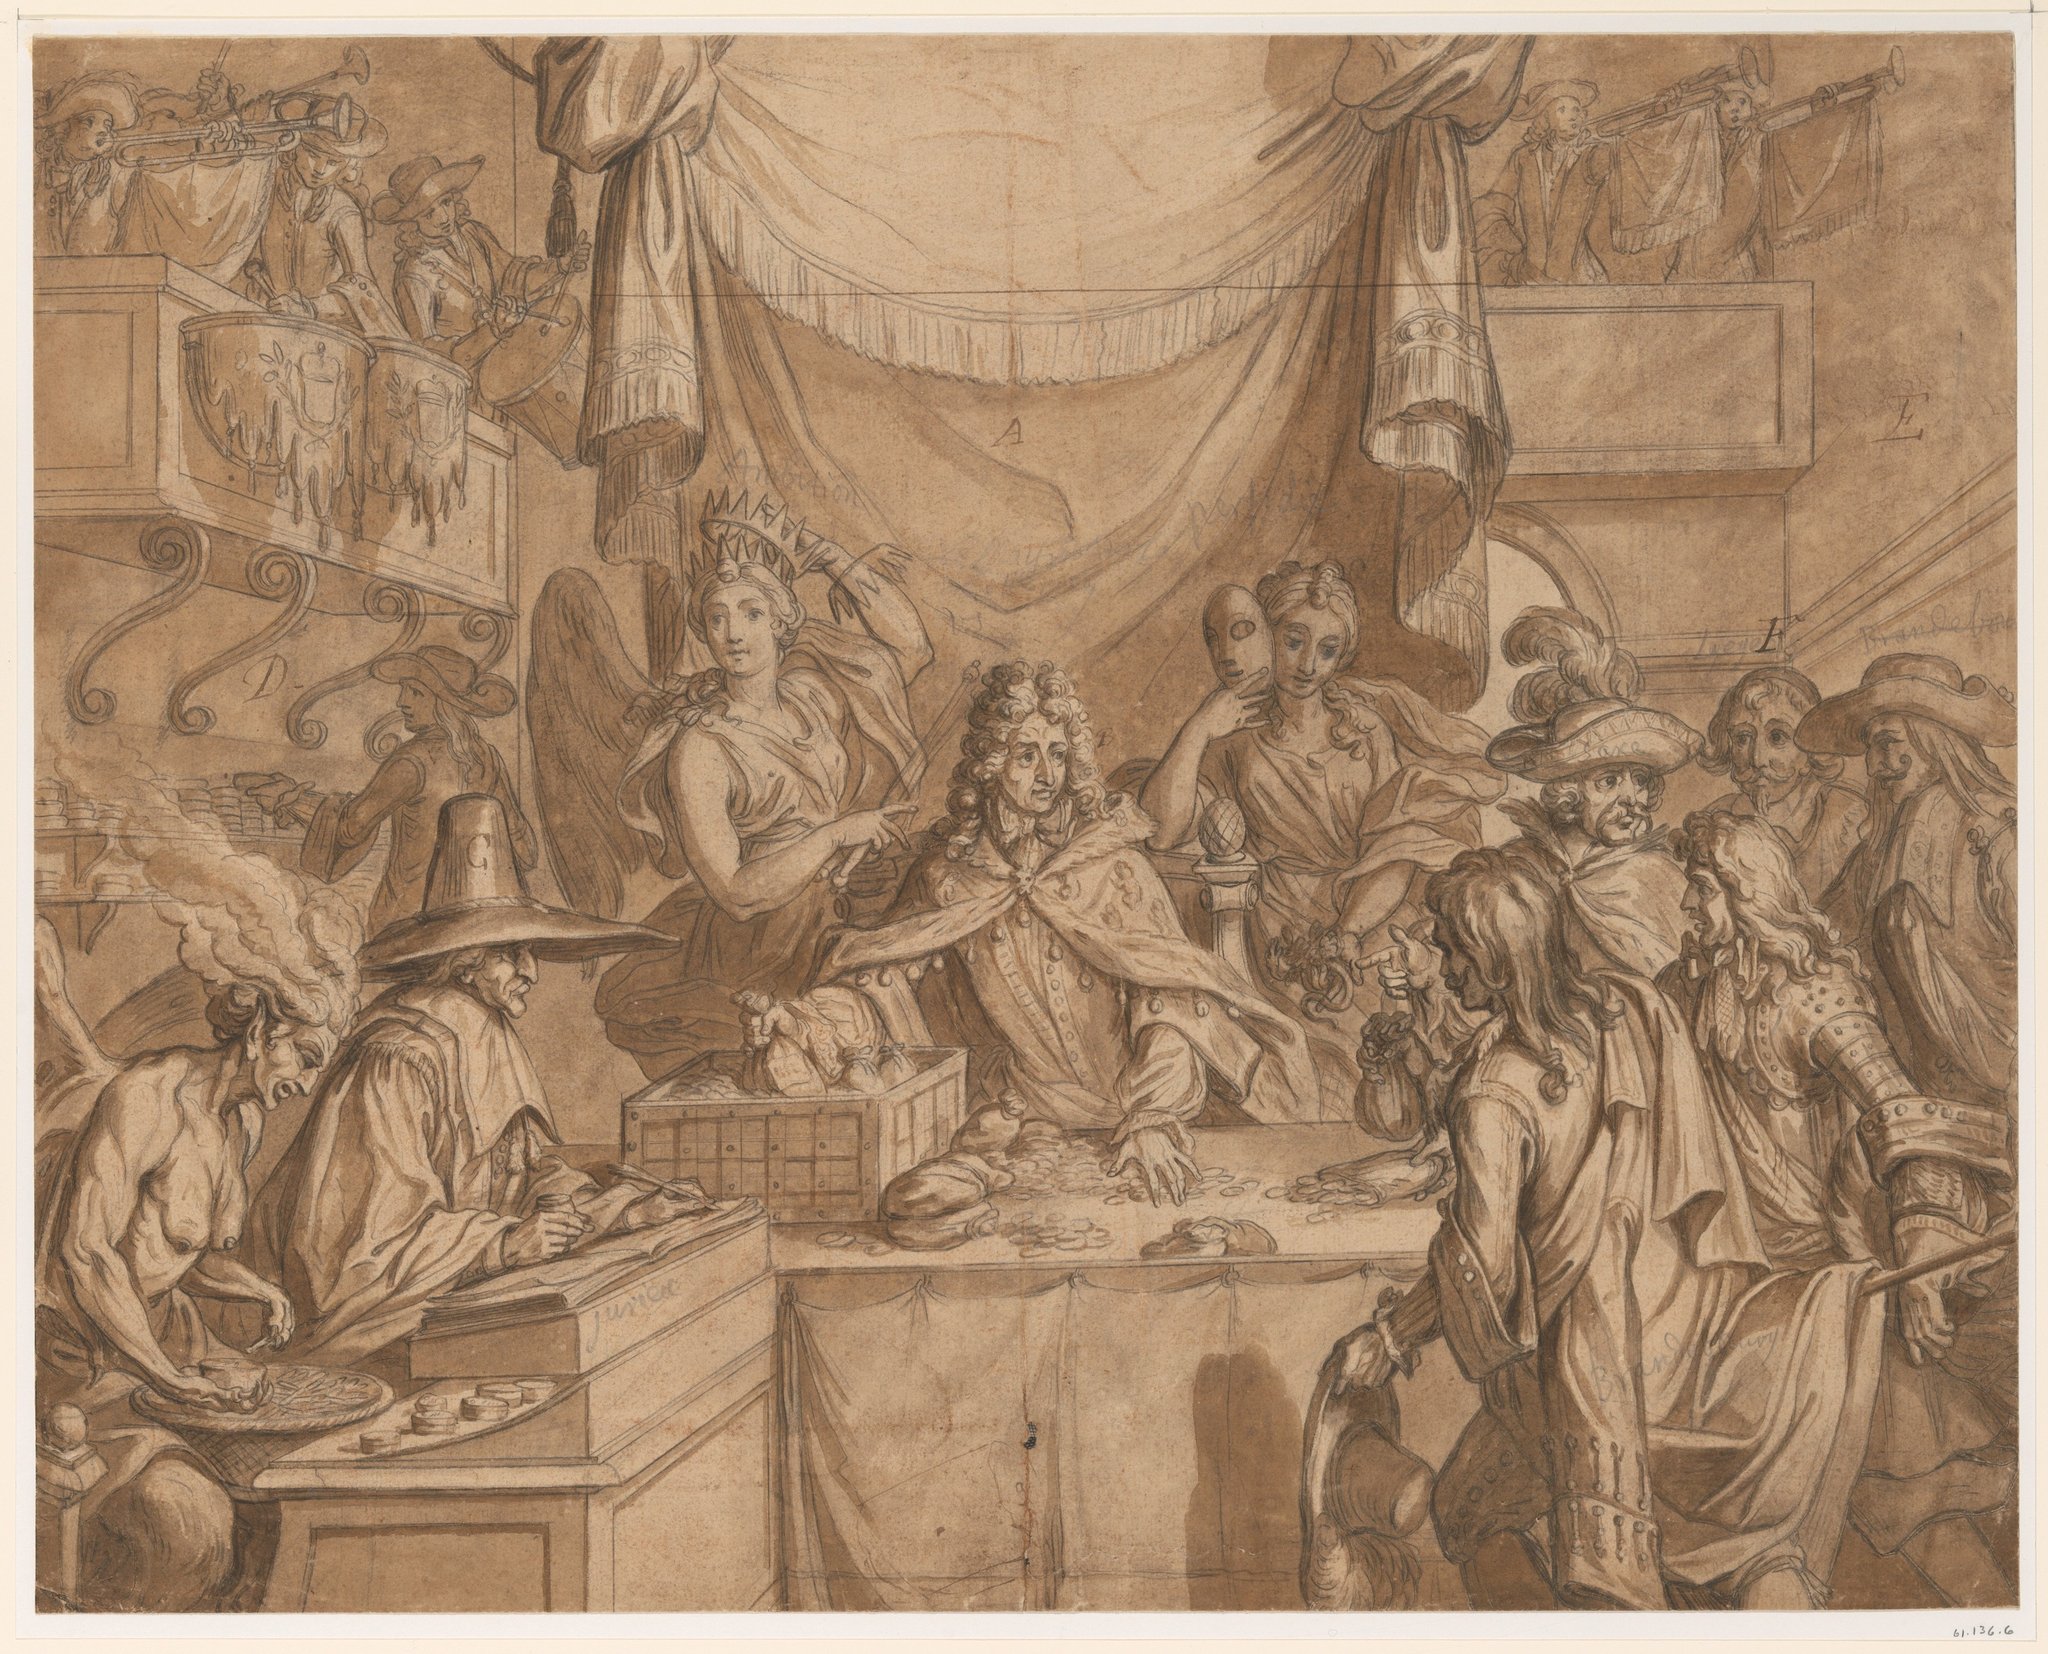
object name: drawing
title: Study for an engraving: "Almanac pour l'an de Bissexte M.DC.XCII: La Lotterie Chimerique d'Augsbourg où chacun met du sien sans proffit"[sic]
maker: anonymous, french, 17th century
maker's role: artist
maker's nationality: french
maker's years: 1600-1700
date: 1667-1700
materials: chalk, ink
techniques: pen, transfer, wash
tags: men,women